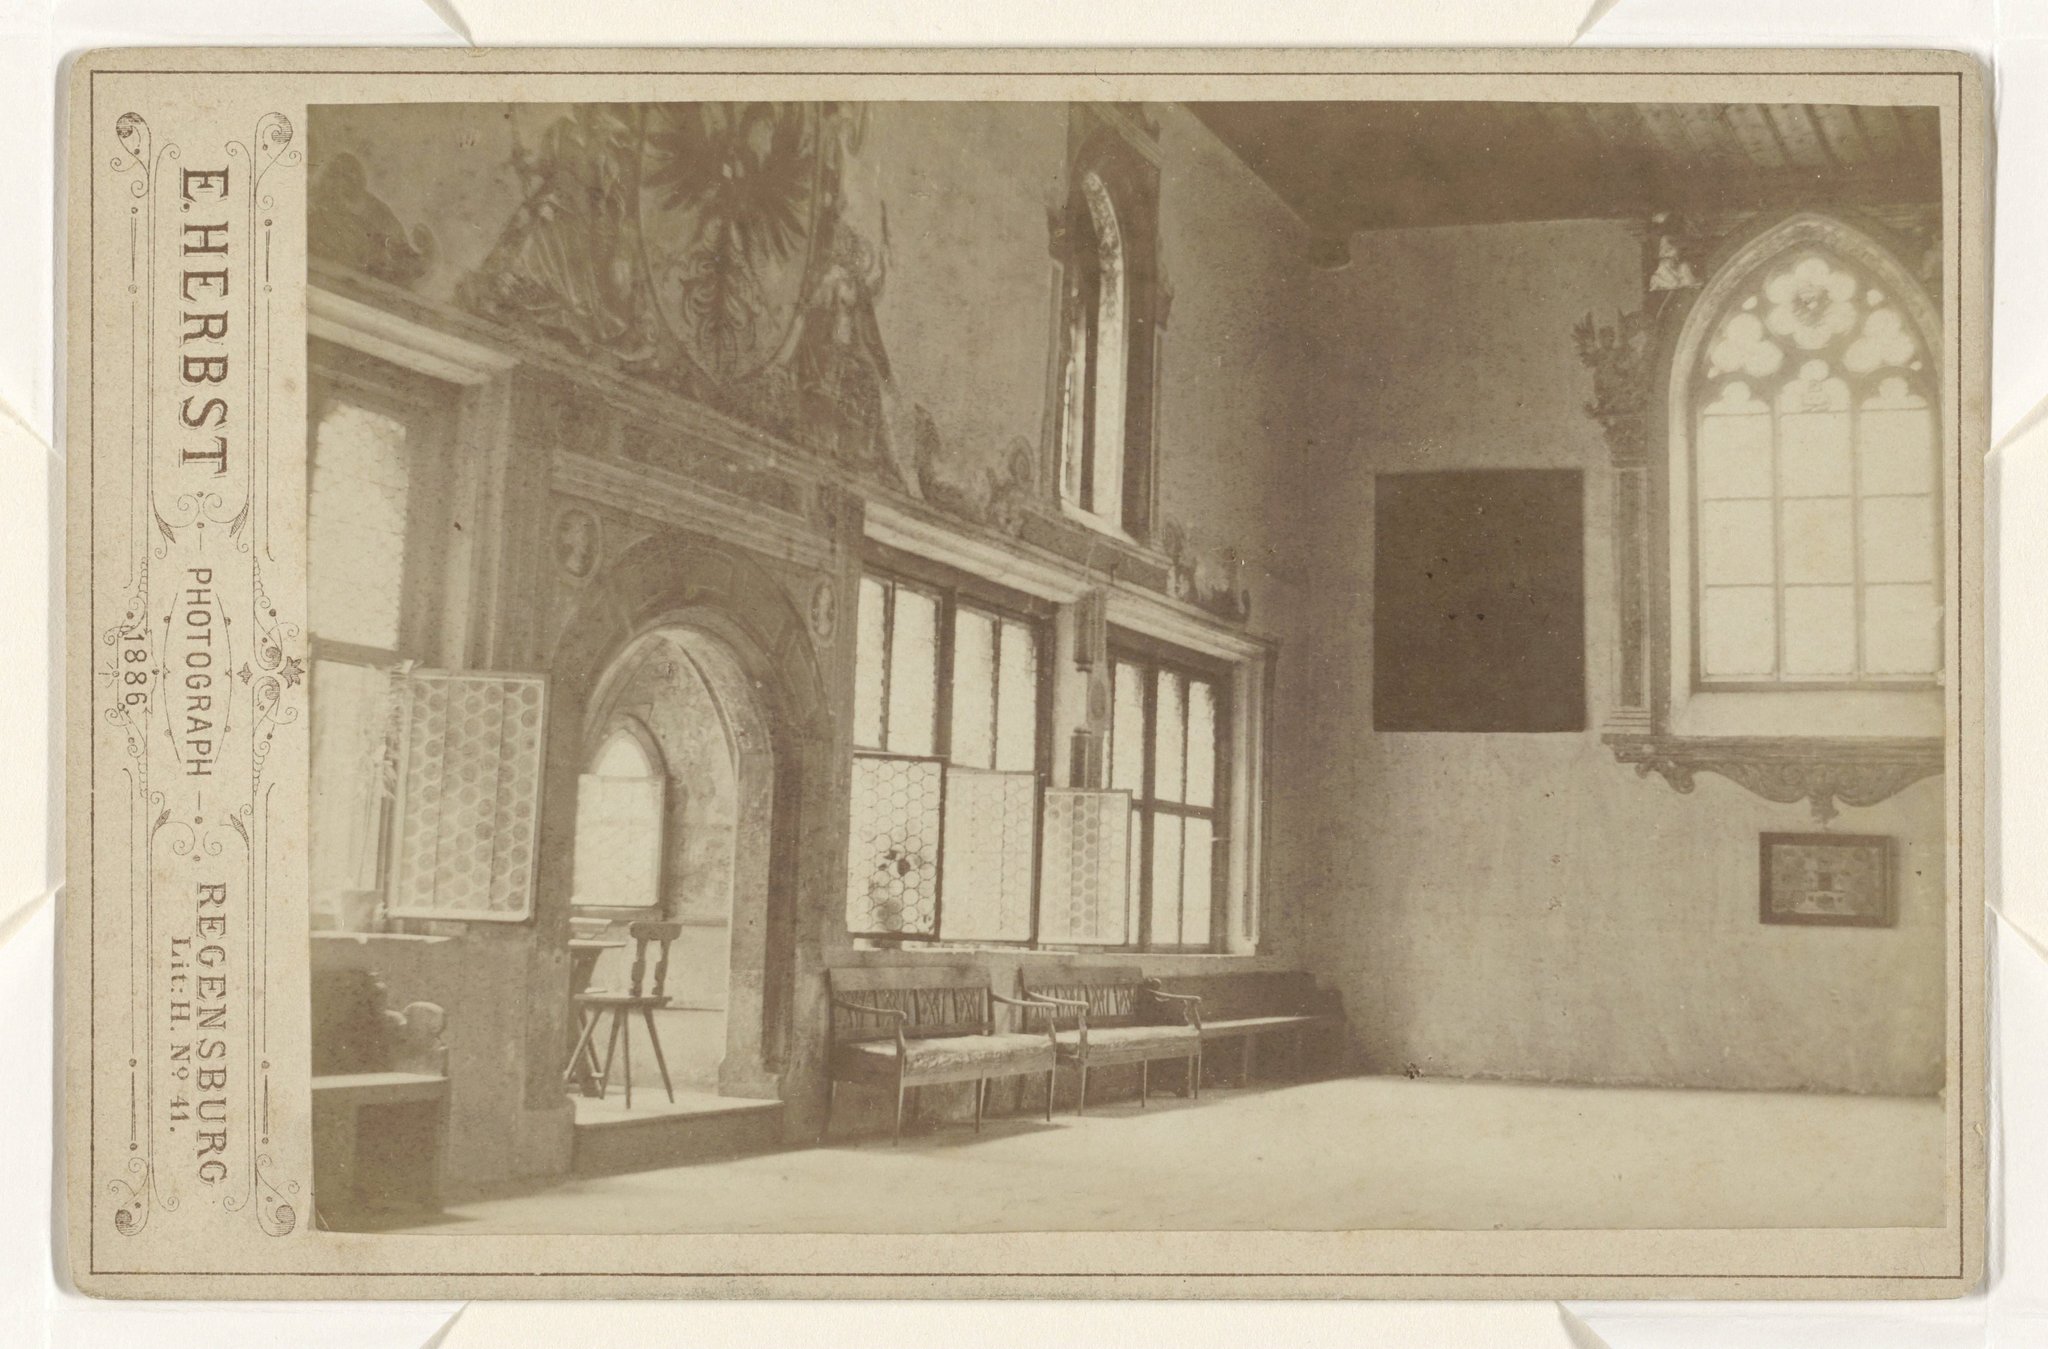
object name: cabinet photograph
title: Interieur van een huis of kerk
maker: emil herbst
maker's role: fotograaf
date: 1886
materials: cardboard, paper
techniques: albumen print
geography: regensburg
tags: townhall, interior of the house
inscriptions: inscription: ‘E. Herbst/ Photograph/ 1886/ Regensburg/ Lit: H. No 41.’